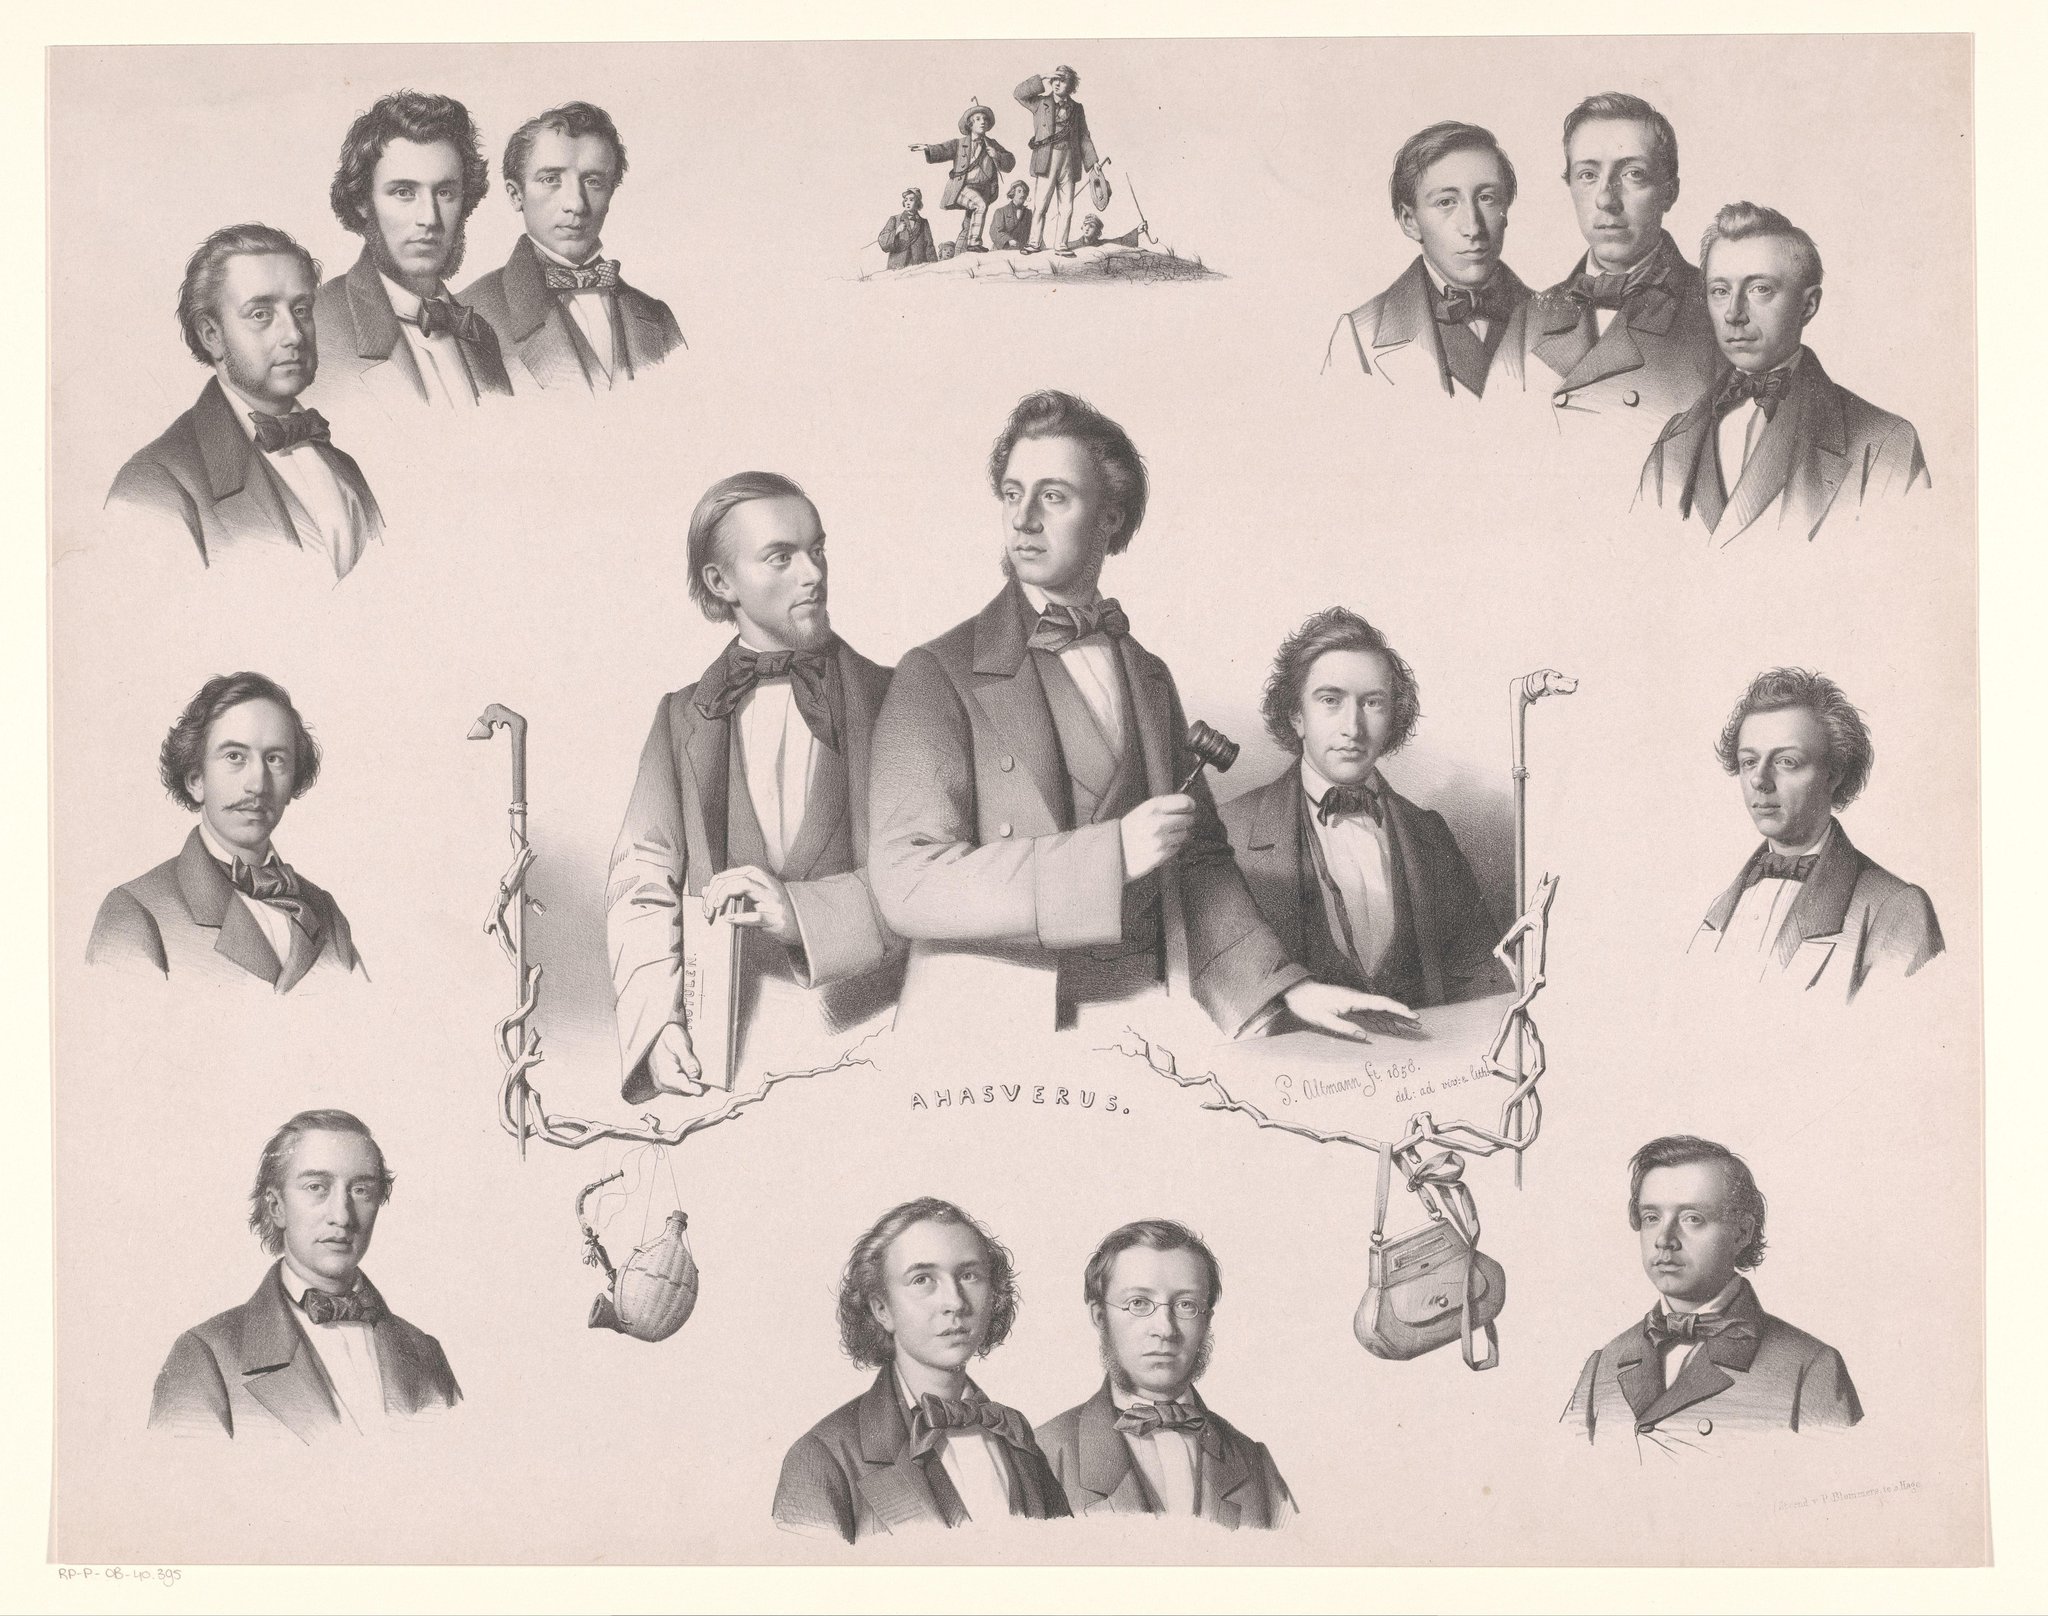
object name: print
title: Portretten van leden van wandelgezelschap Ahasverus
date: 1858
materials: paper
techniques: lithograph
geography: the hague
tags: walking, hiking (recreation), anonymous historical person portrayed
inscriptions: collector's mark: Lugt 2228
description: Portretten van vijftien jongemannen en een groep wandelaars.